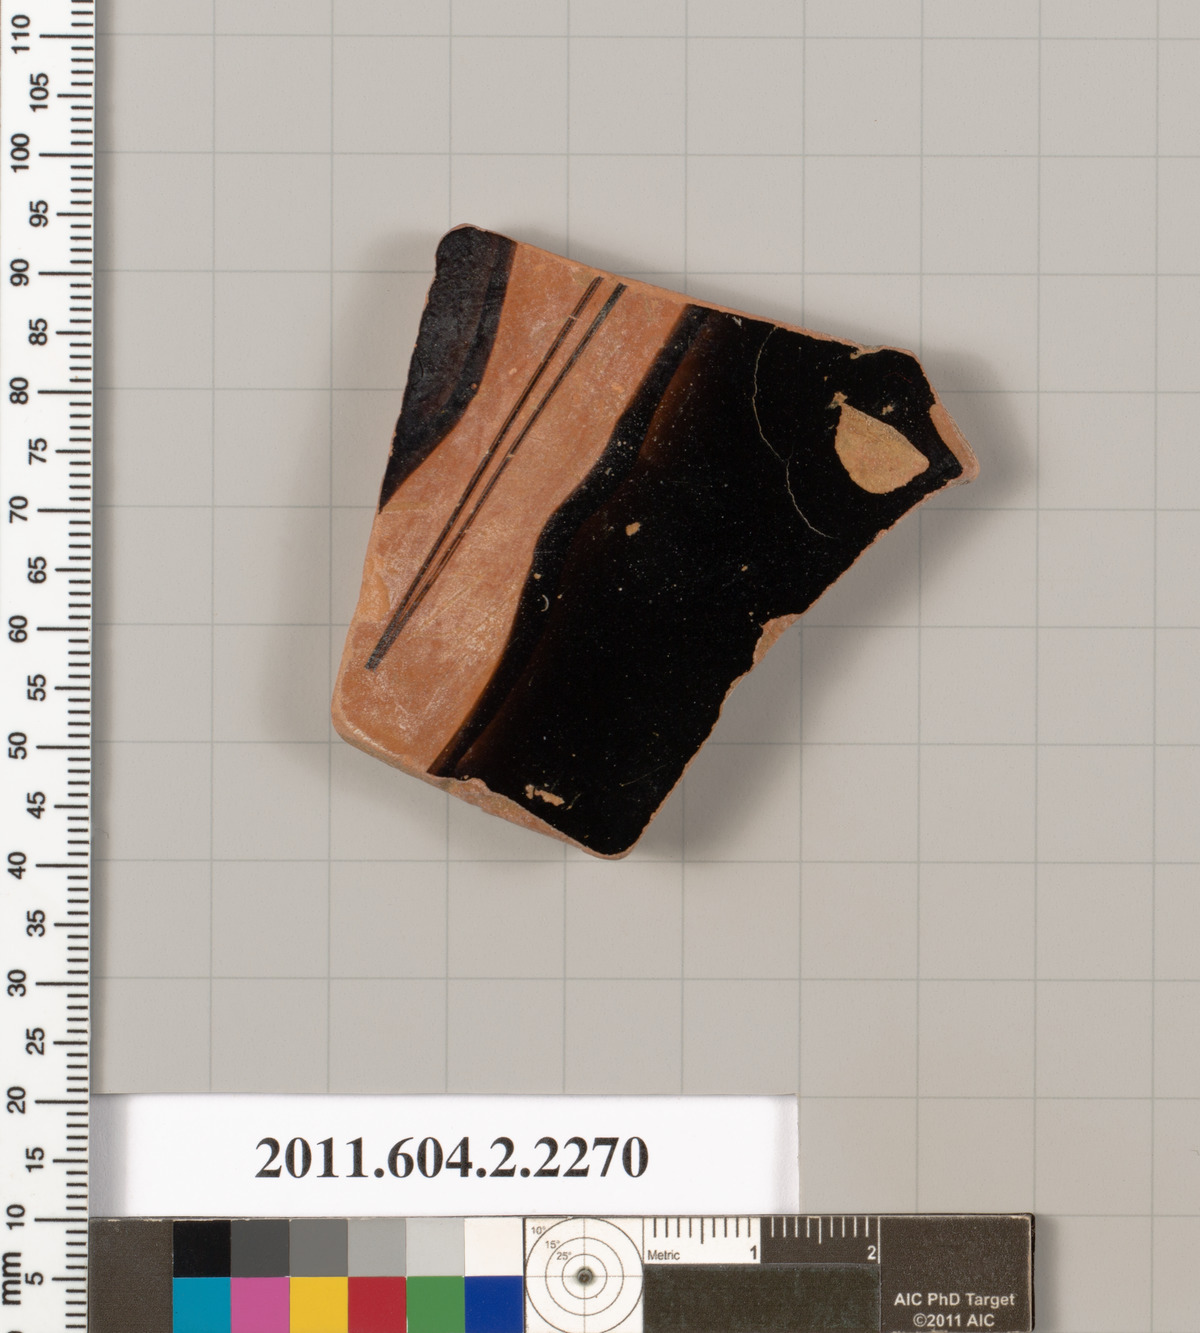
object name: krater fragment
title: Terracotta fragment of a krater (bowl for mixing wine and water)?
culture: greek, attic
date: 475-451 BCE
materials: terracotta